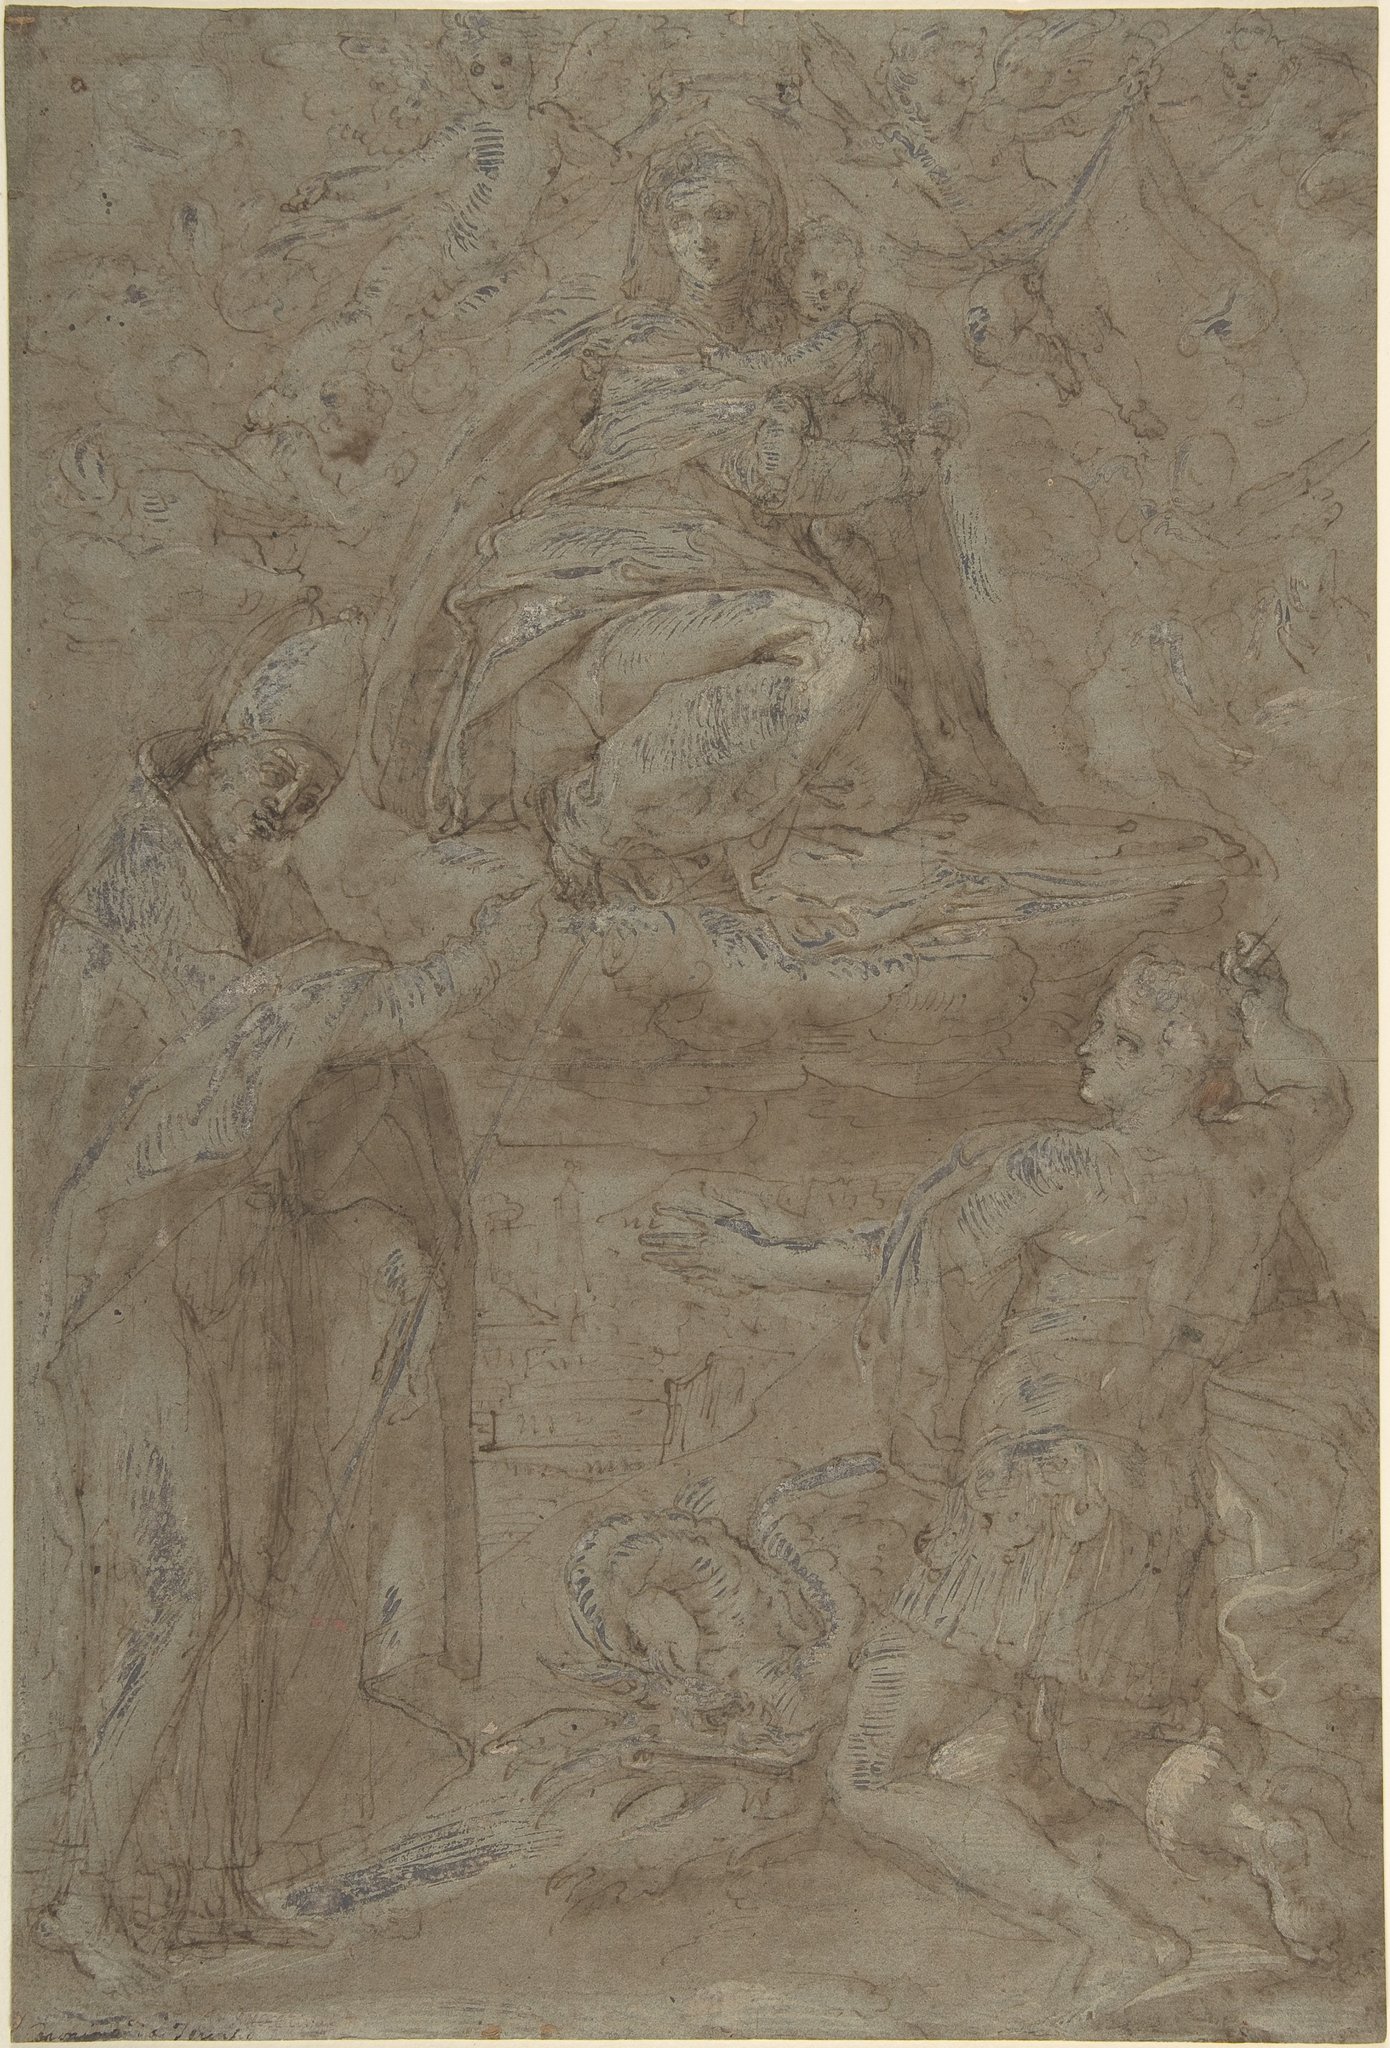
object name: drawing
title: Madonna in Glory with Two Saints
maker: anonymous, italian, late 16th century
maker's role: artist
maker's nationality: italian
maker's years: 1550-1600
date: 1567-1600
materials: ink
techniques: brush, highlighting, pen, wash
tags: animals,angels,madonna and child,saints